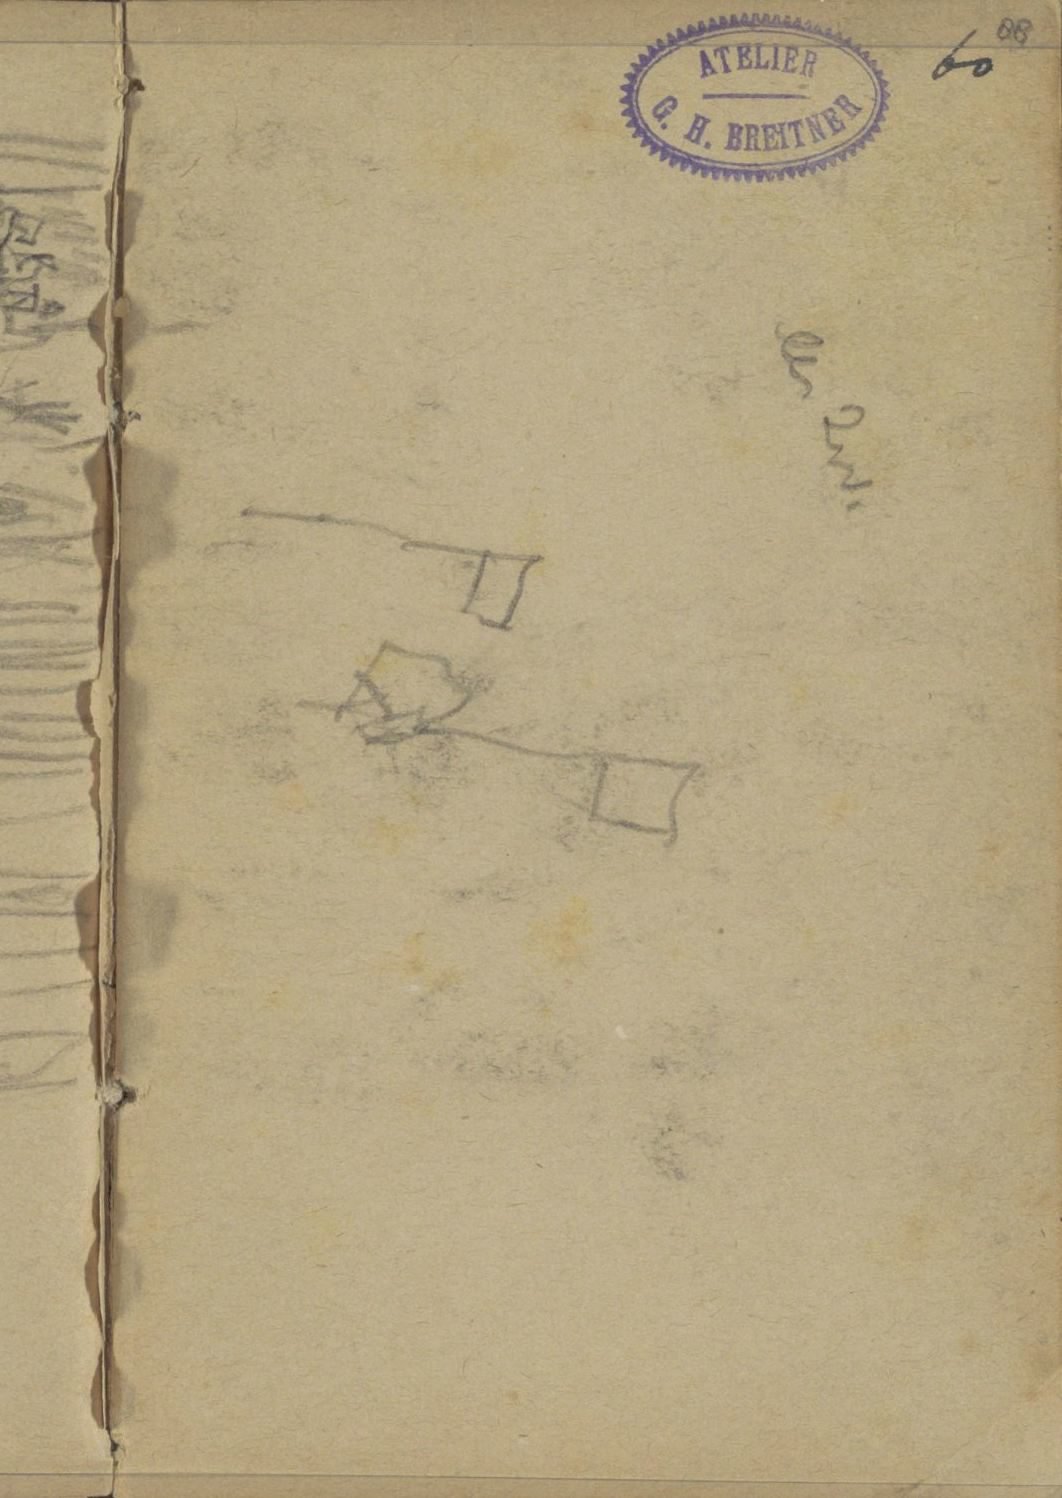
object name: sketchbook leaf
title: Hoofd van een soldaat en twee vlaggen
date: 1887-1891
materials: paper, pencil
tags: head (human), division of armed forces (+ land forces), (military) flags and standards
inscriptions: annotation: ‘[...]’, workshop stamp: Lugt 291d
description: Pagina 88 uit een schetsboek met 83 bladen.